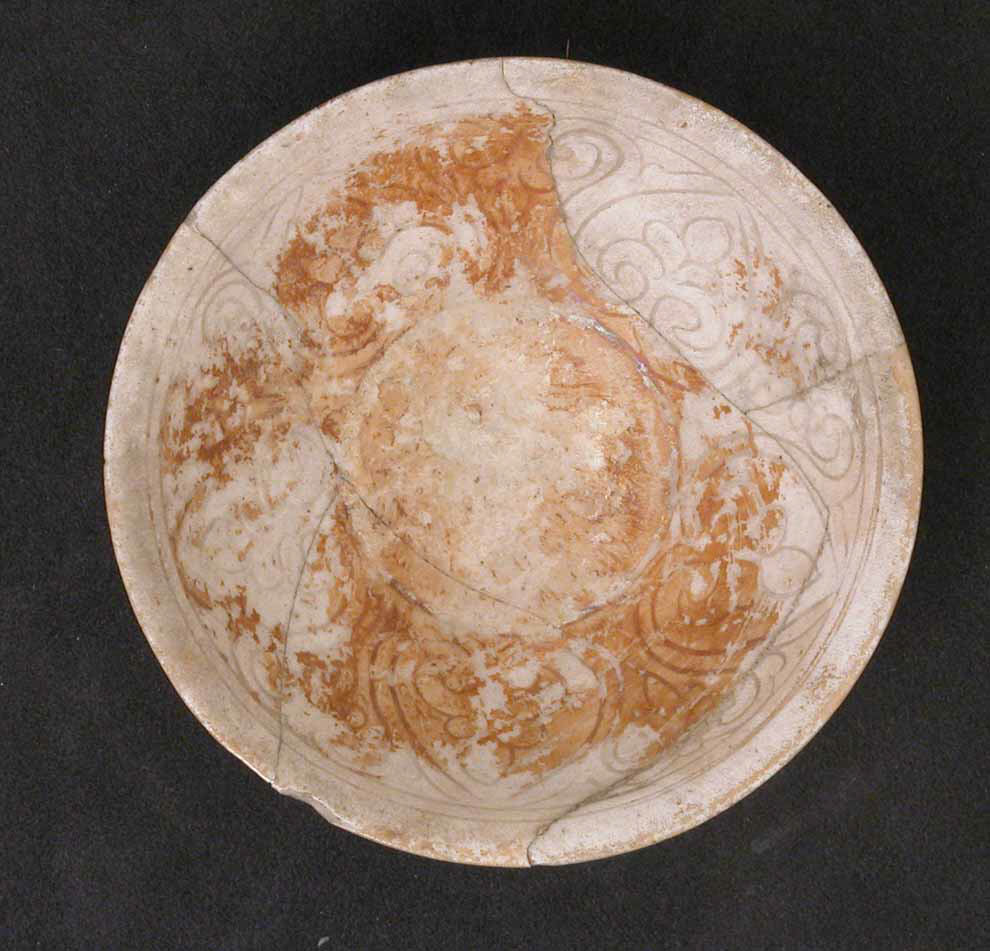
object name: bowl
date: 1101-1300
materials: stonepaste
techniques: glazing, incising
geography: iran